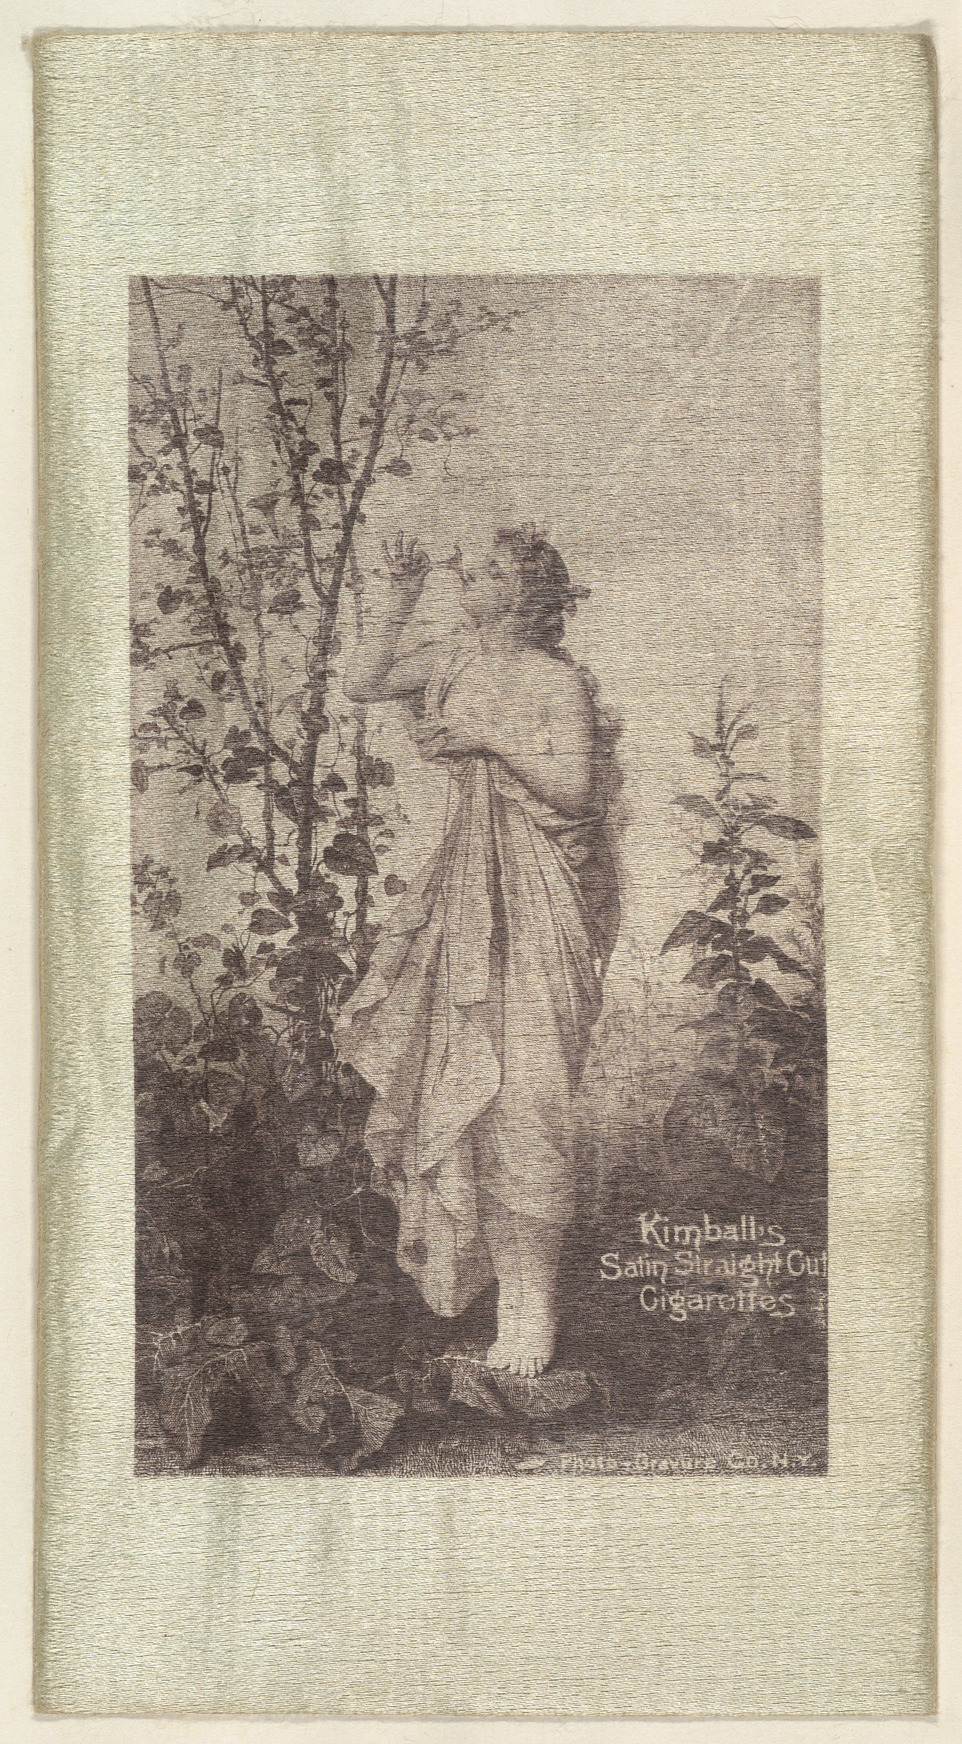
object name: print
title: Woman smelling blossom on tree (on green silk), from the Girl Art Subjects series (N193) issued by Wm. S. Kimball & Co.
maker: william s. kimball & company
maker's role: publisher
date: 1890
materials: silk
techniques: lithography, printing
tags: women,flowers,trees